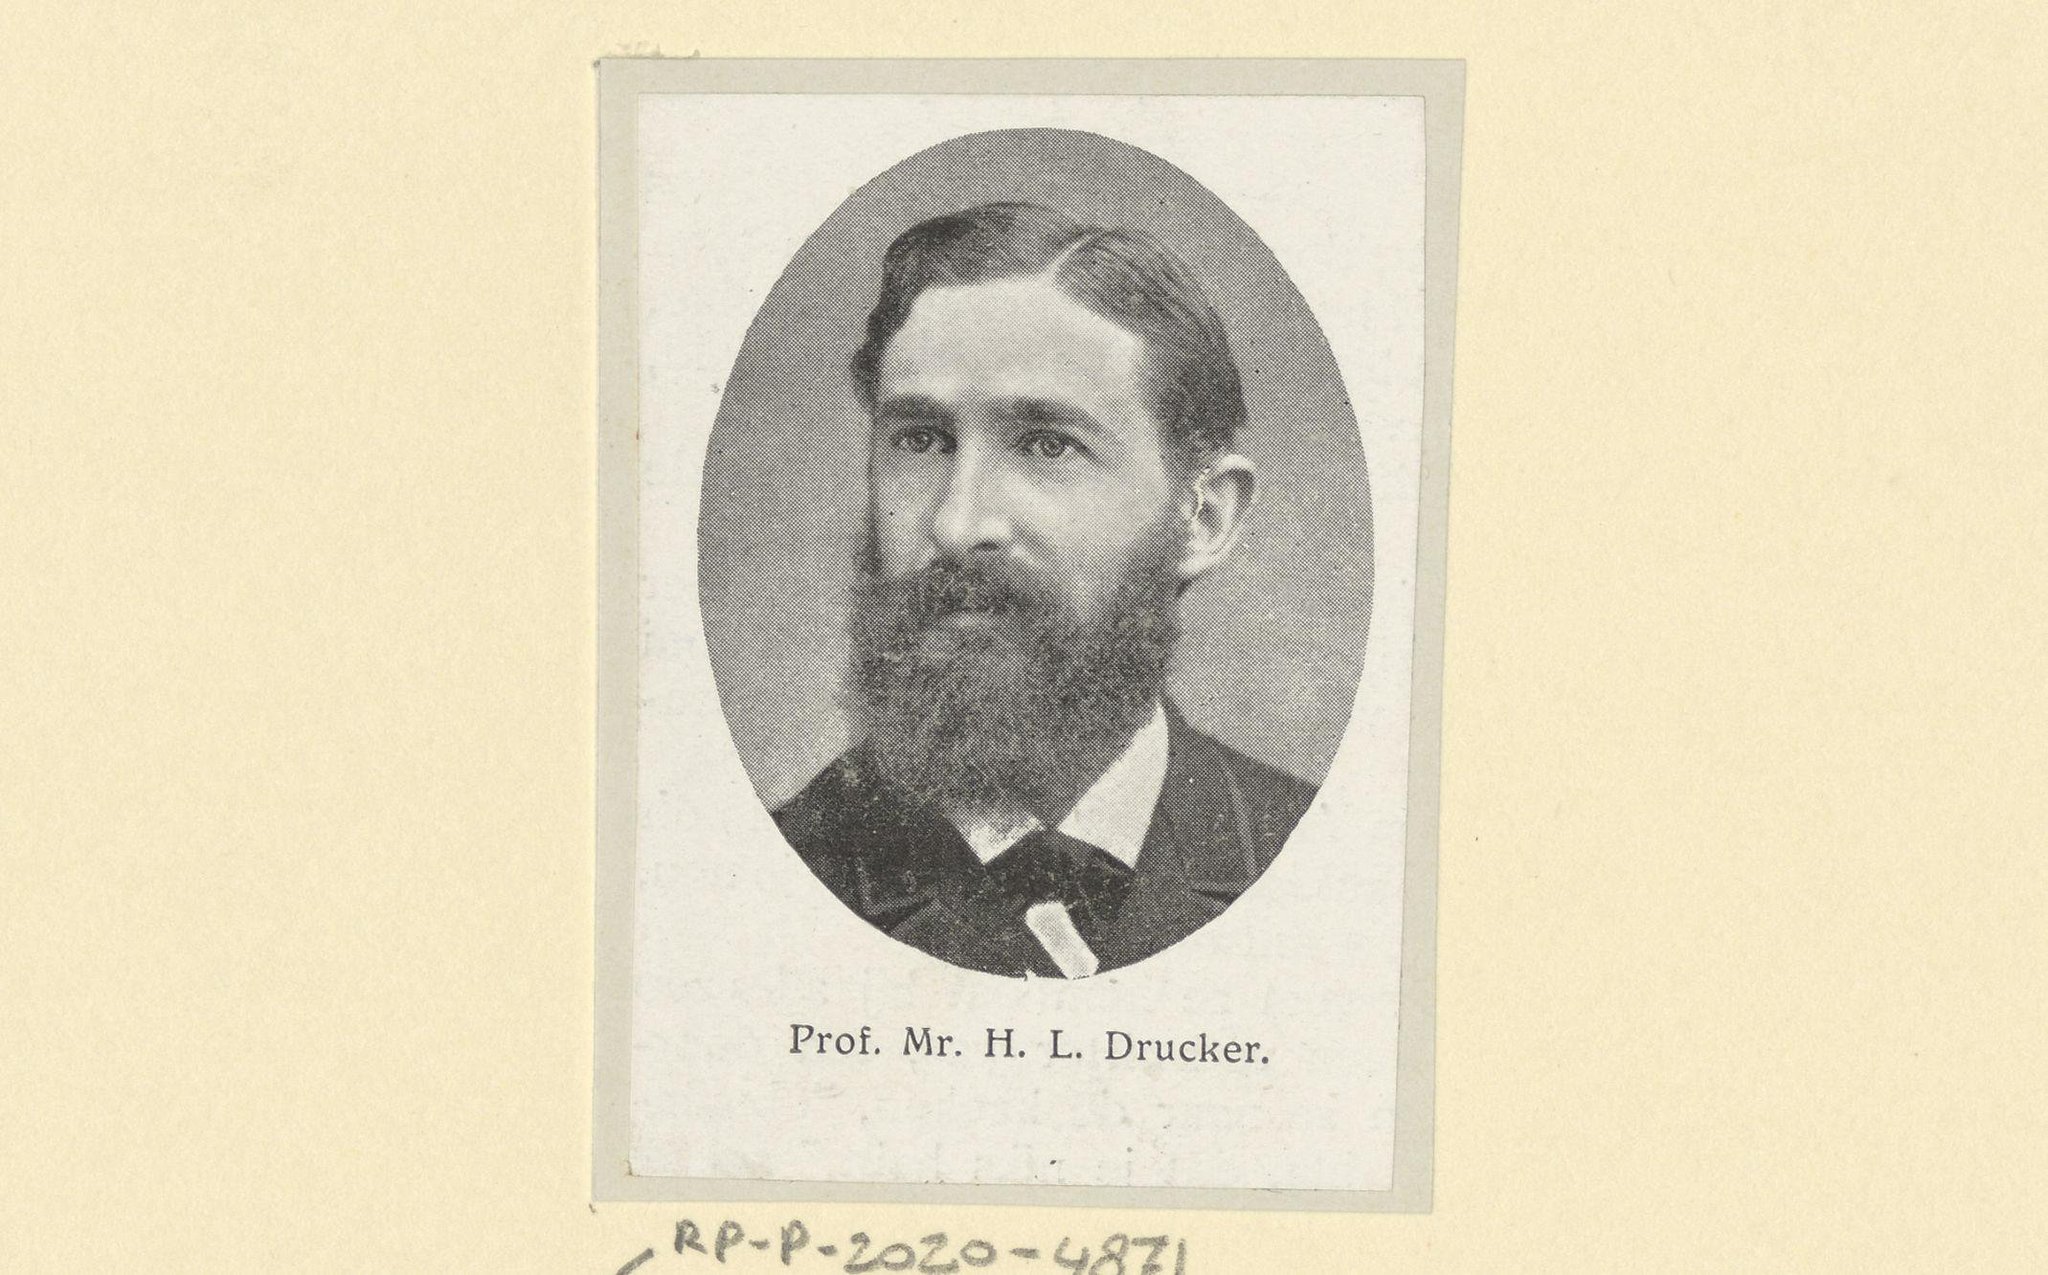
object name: photomechanical print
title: Portret van Hendrik Lodewijk Drucker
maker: Anonymous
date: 1882-1900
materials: paper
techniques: autotype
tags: amsterdam, the hague, politician, historical persons, politician, e.g. party leader